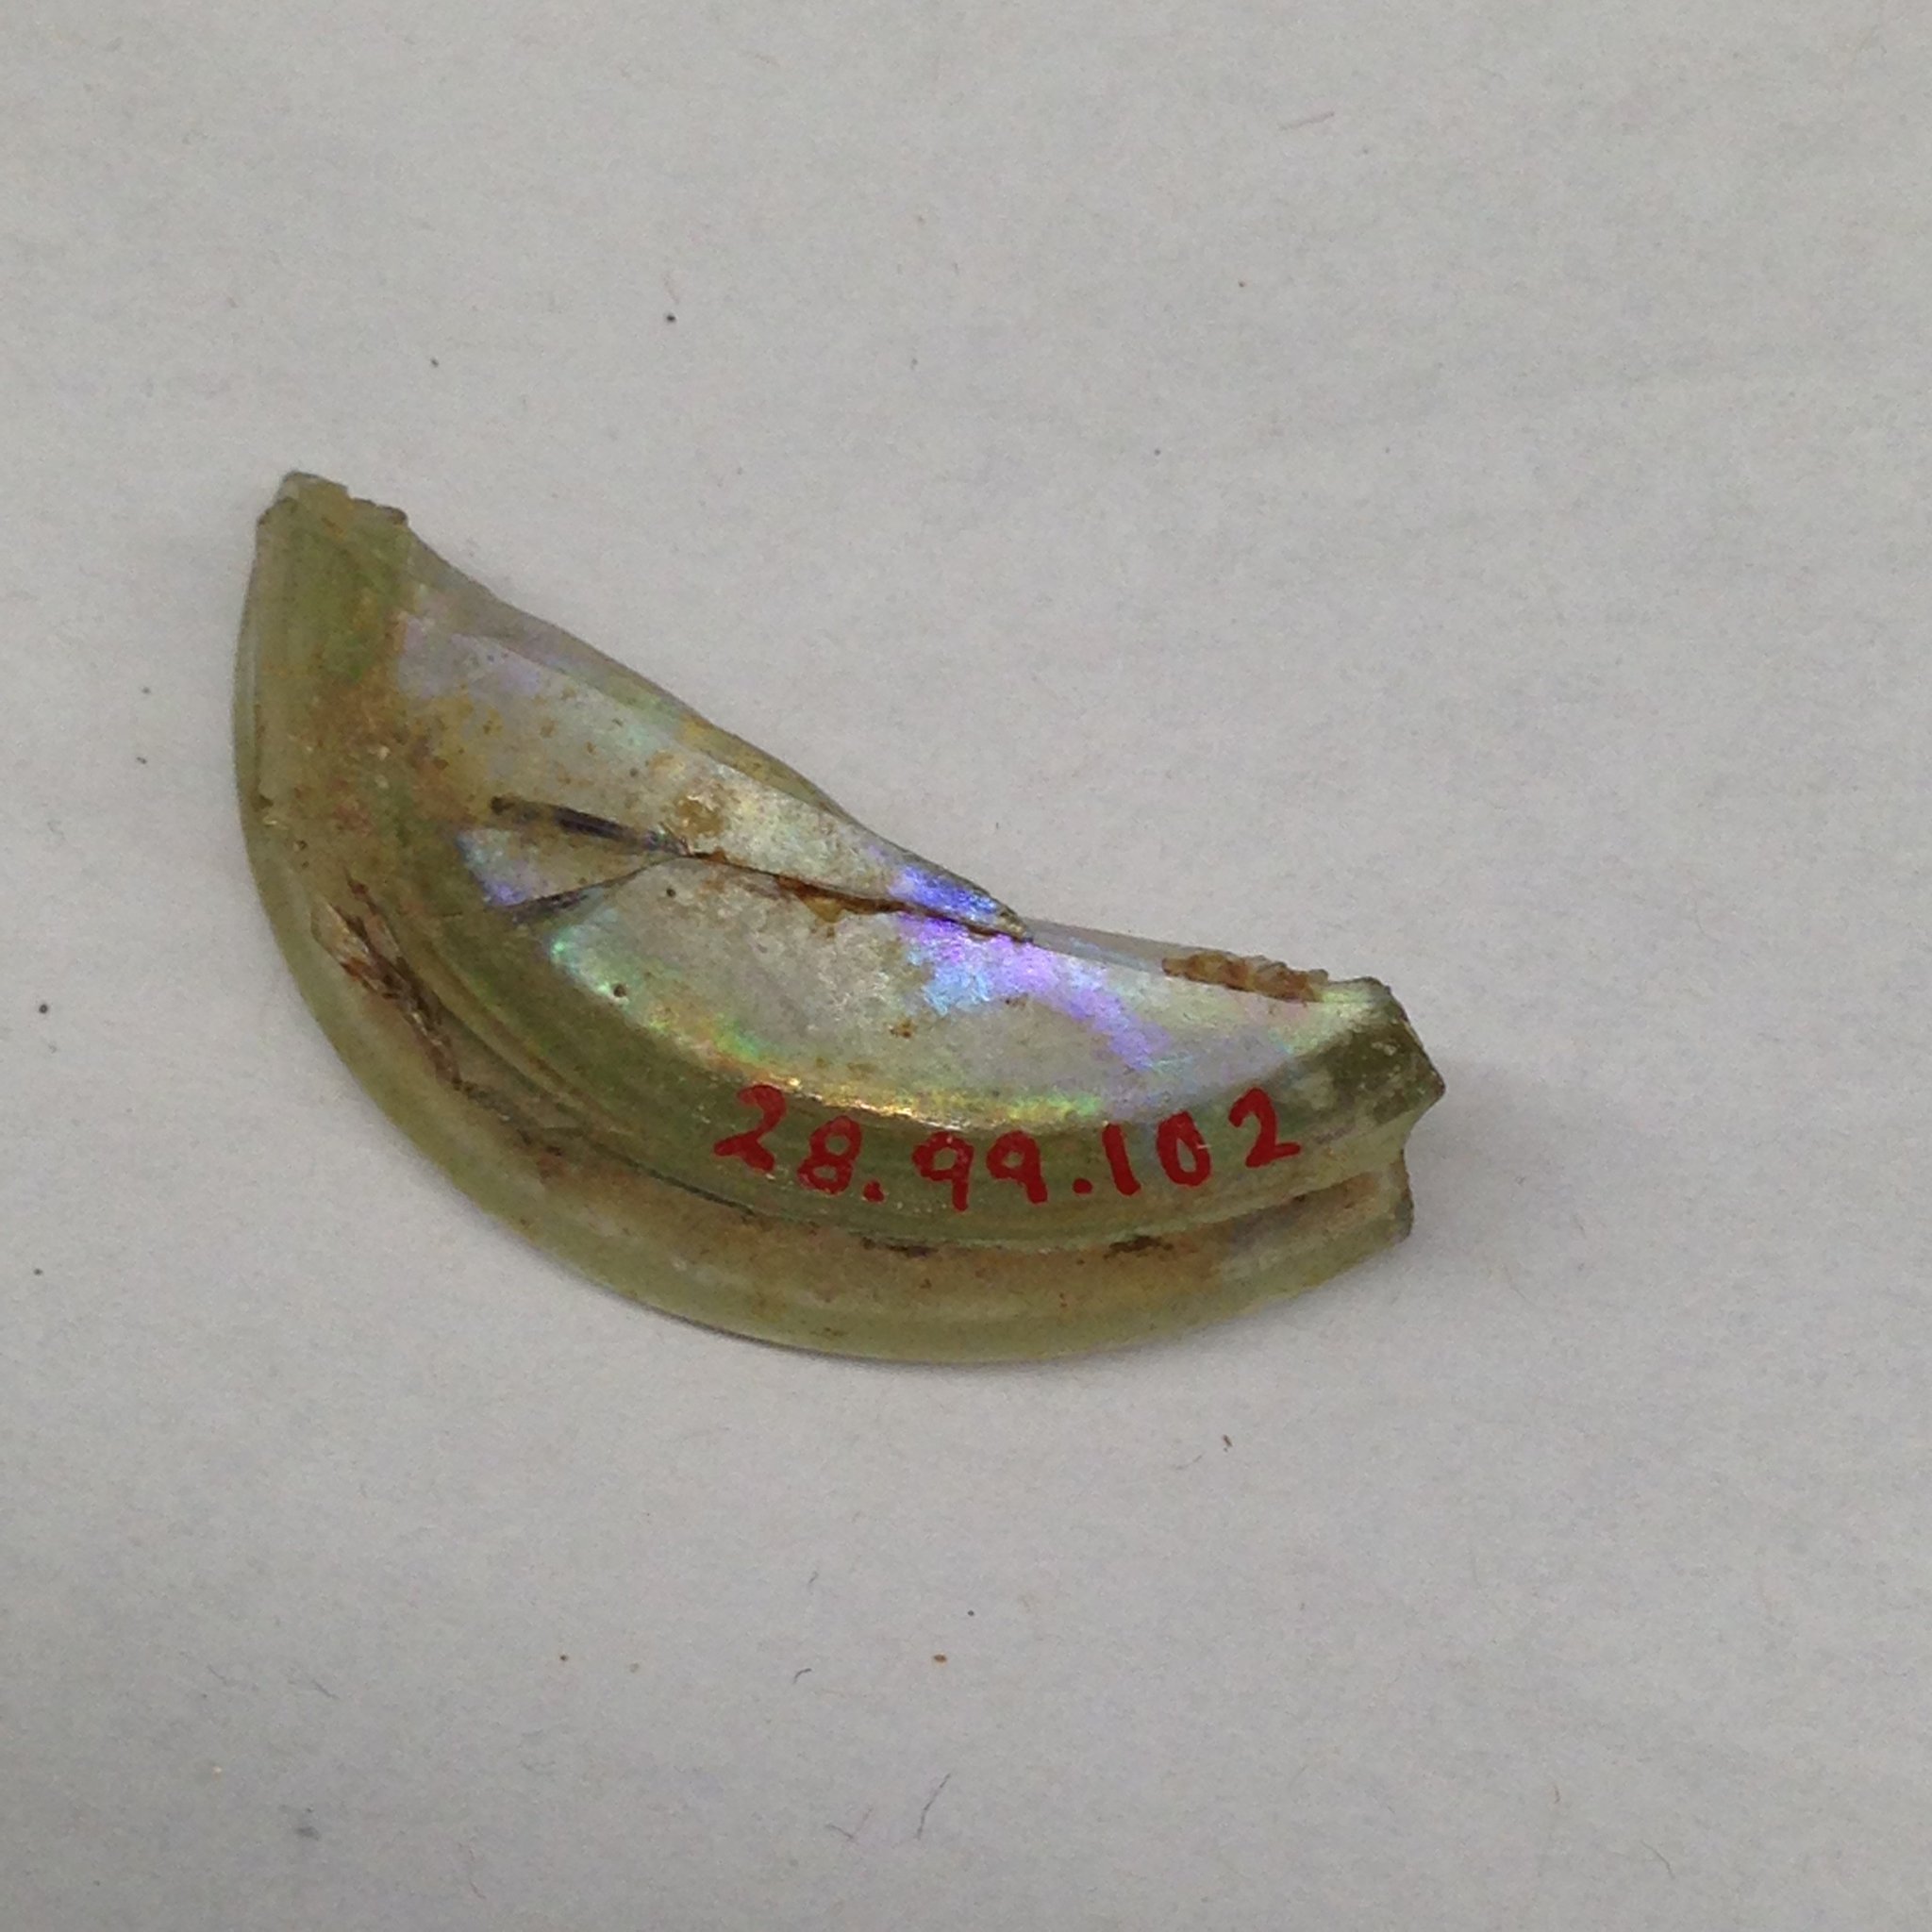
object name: fragment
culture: european or middle eastern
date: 1150-1250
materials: ceramic, glass